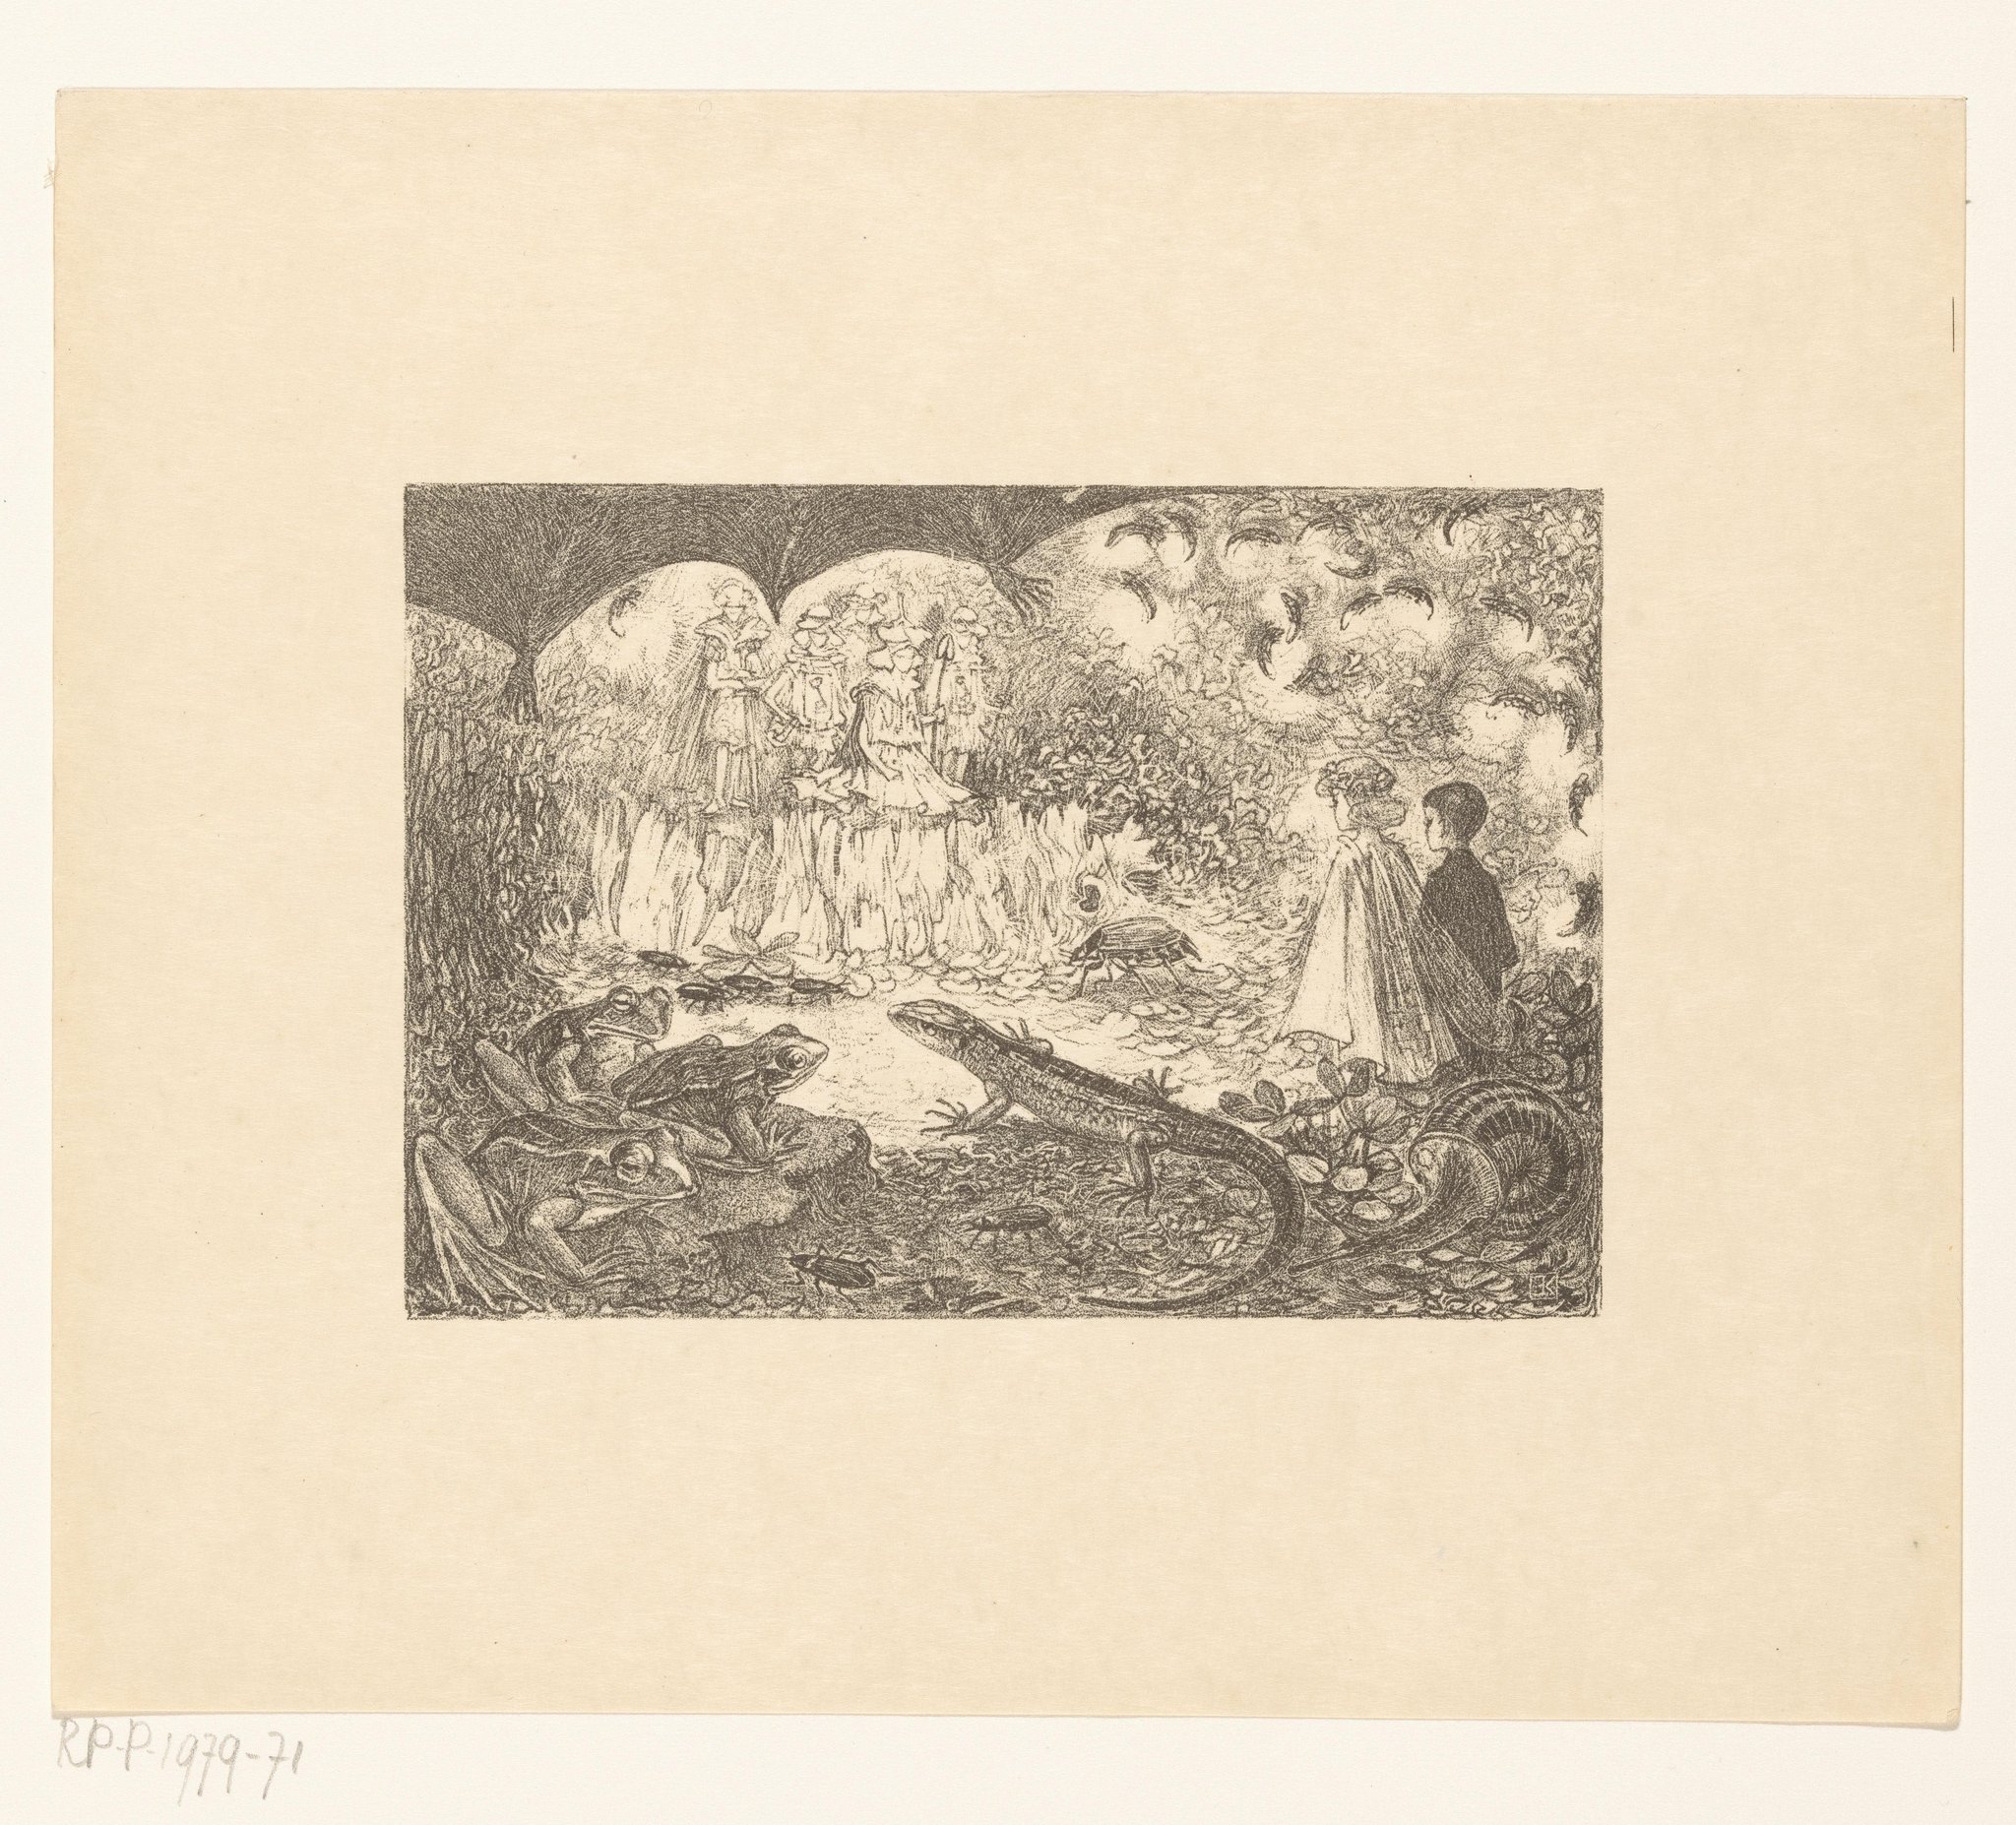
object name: boekillustratie ontwerp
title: Johannes en Windekind bij de elfenkoning Oberon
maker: edzard koning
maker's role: draughtsman, print maker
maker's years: 1869-1954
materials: paper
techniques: lithograph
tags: animals, elf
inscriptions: collector's mark: Lugt 2228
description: Op de voorgrond kikkers, een hagedis, een slak en kevers. Linksboven het onderlijf van een vleermuis. Op de achtergrond zit Oberon op een troon. Hij wordt omringd door andere elfen.